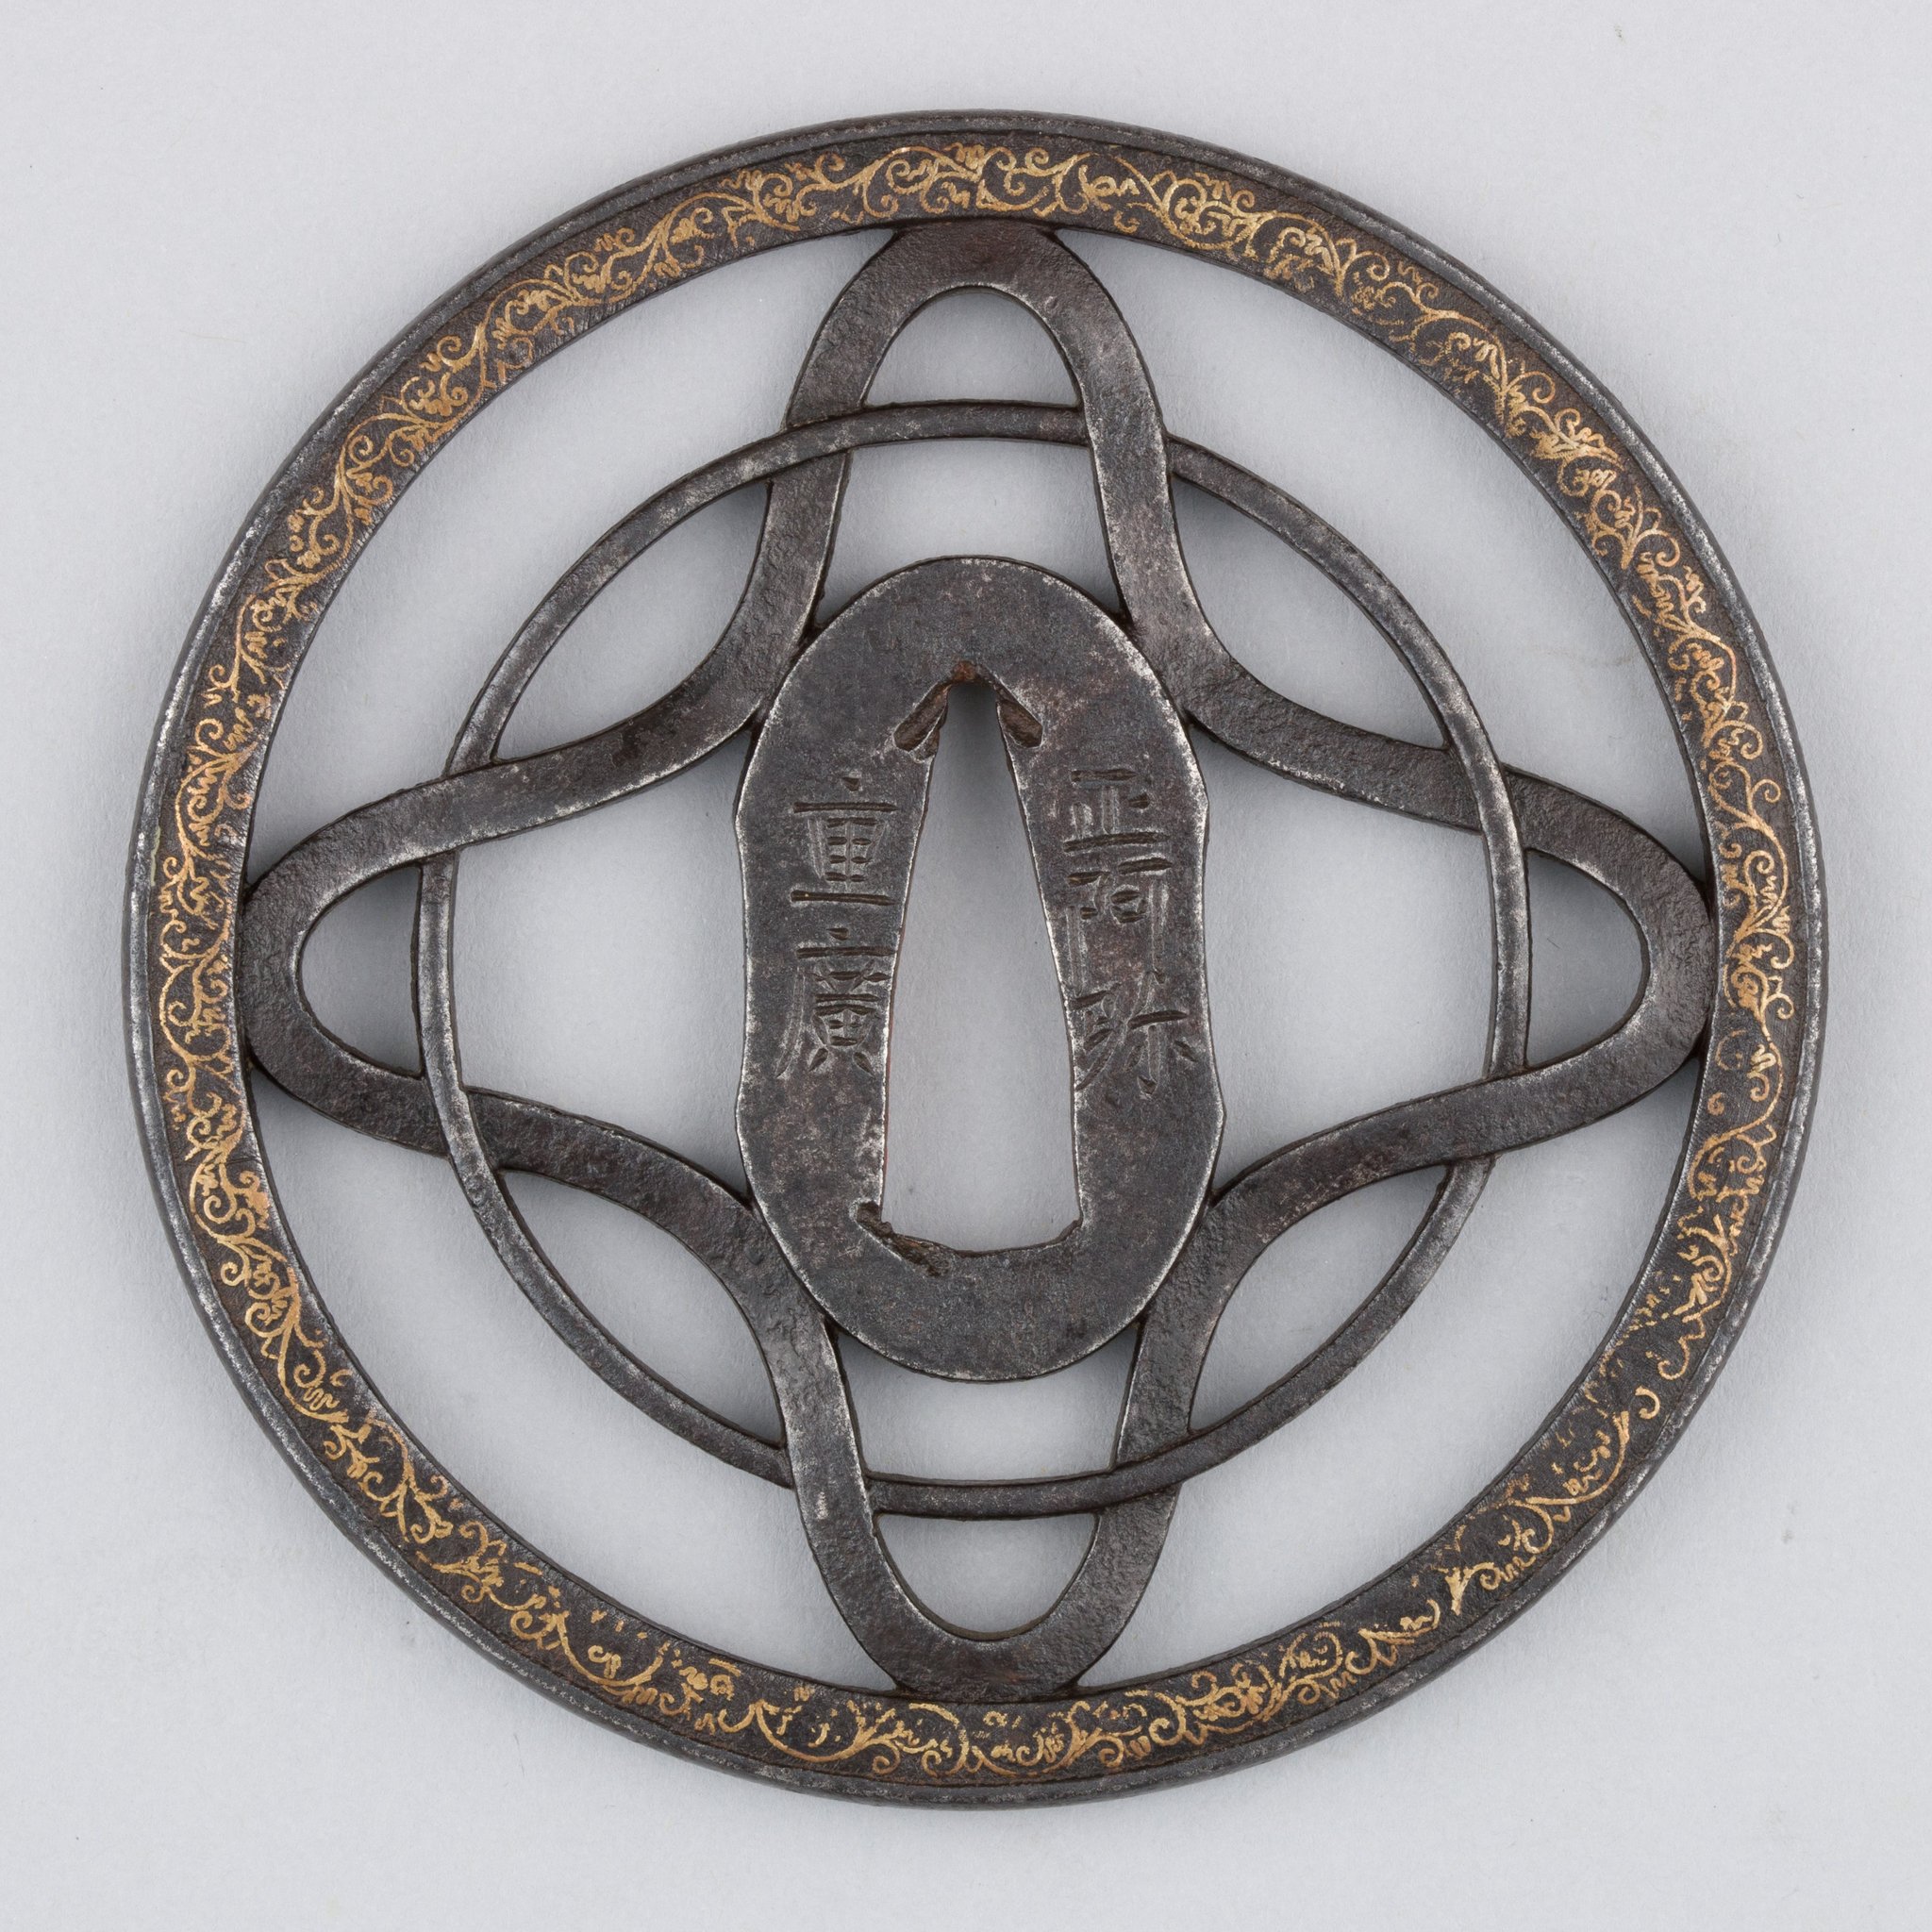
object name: sword guard tsuba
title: Sword Guard (Tsuba)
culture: japanese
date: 1701-1800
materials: copper, gold, iron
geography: japan